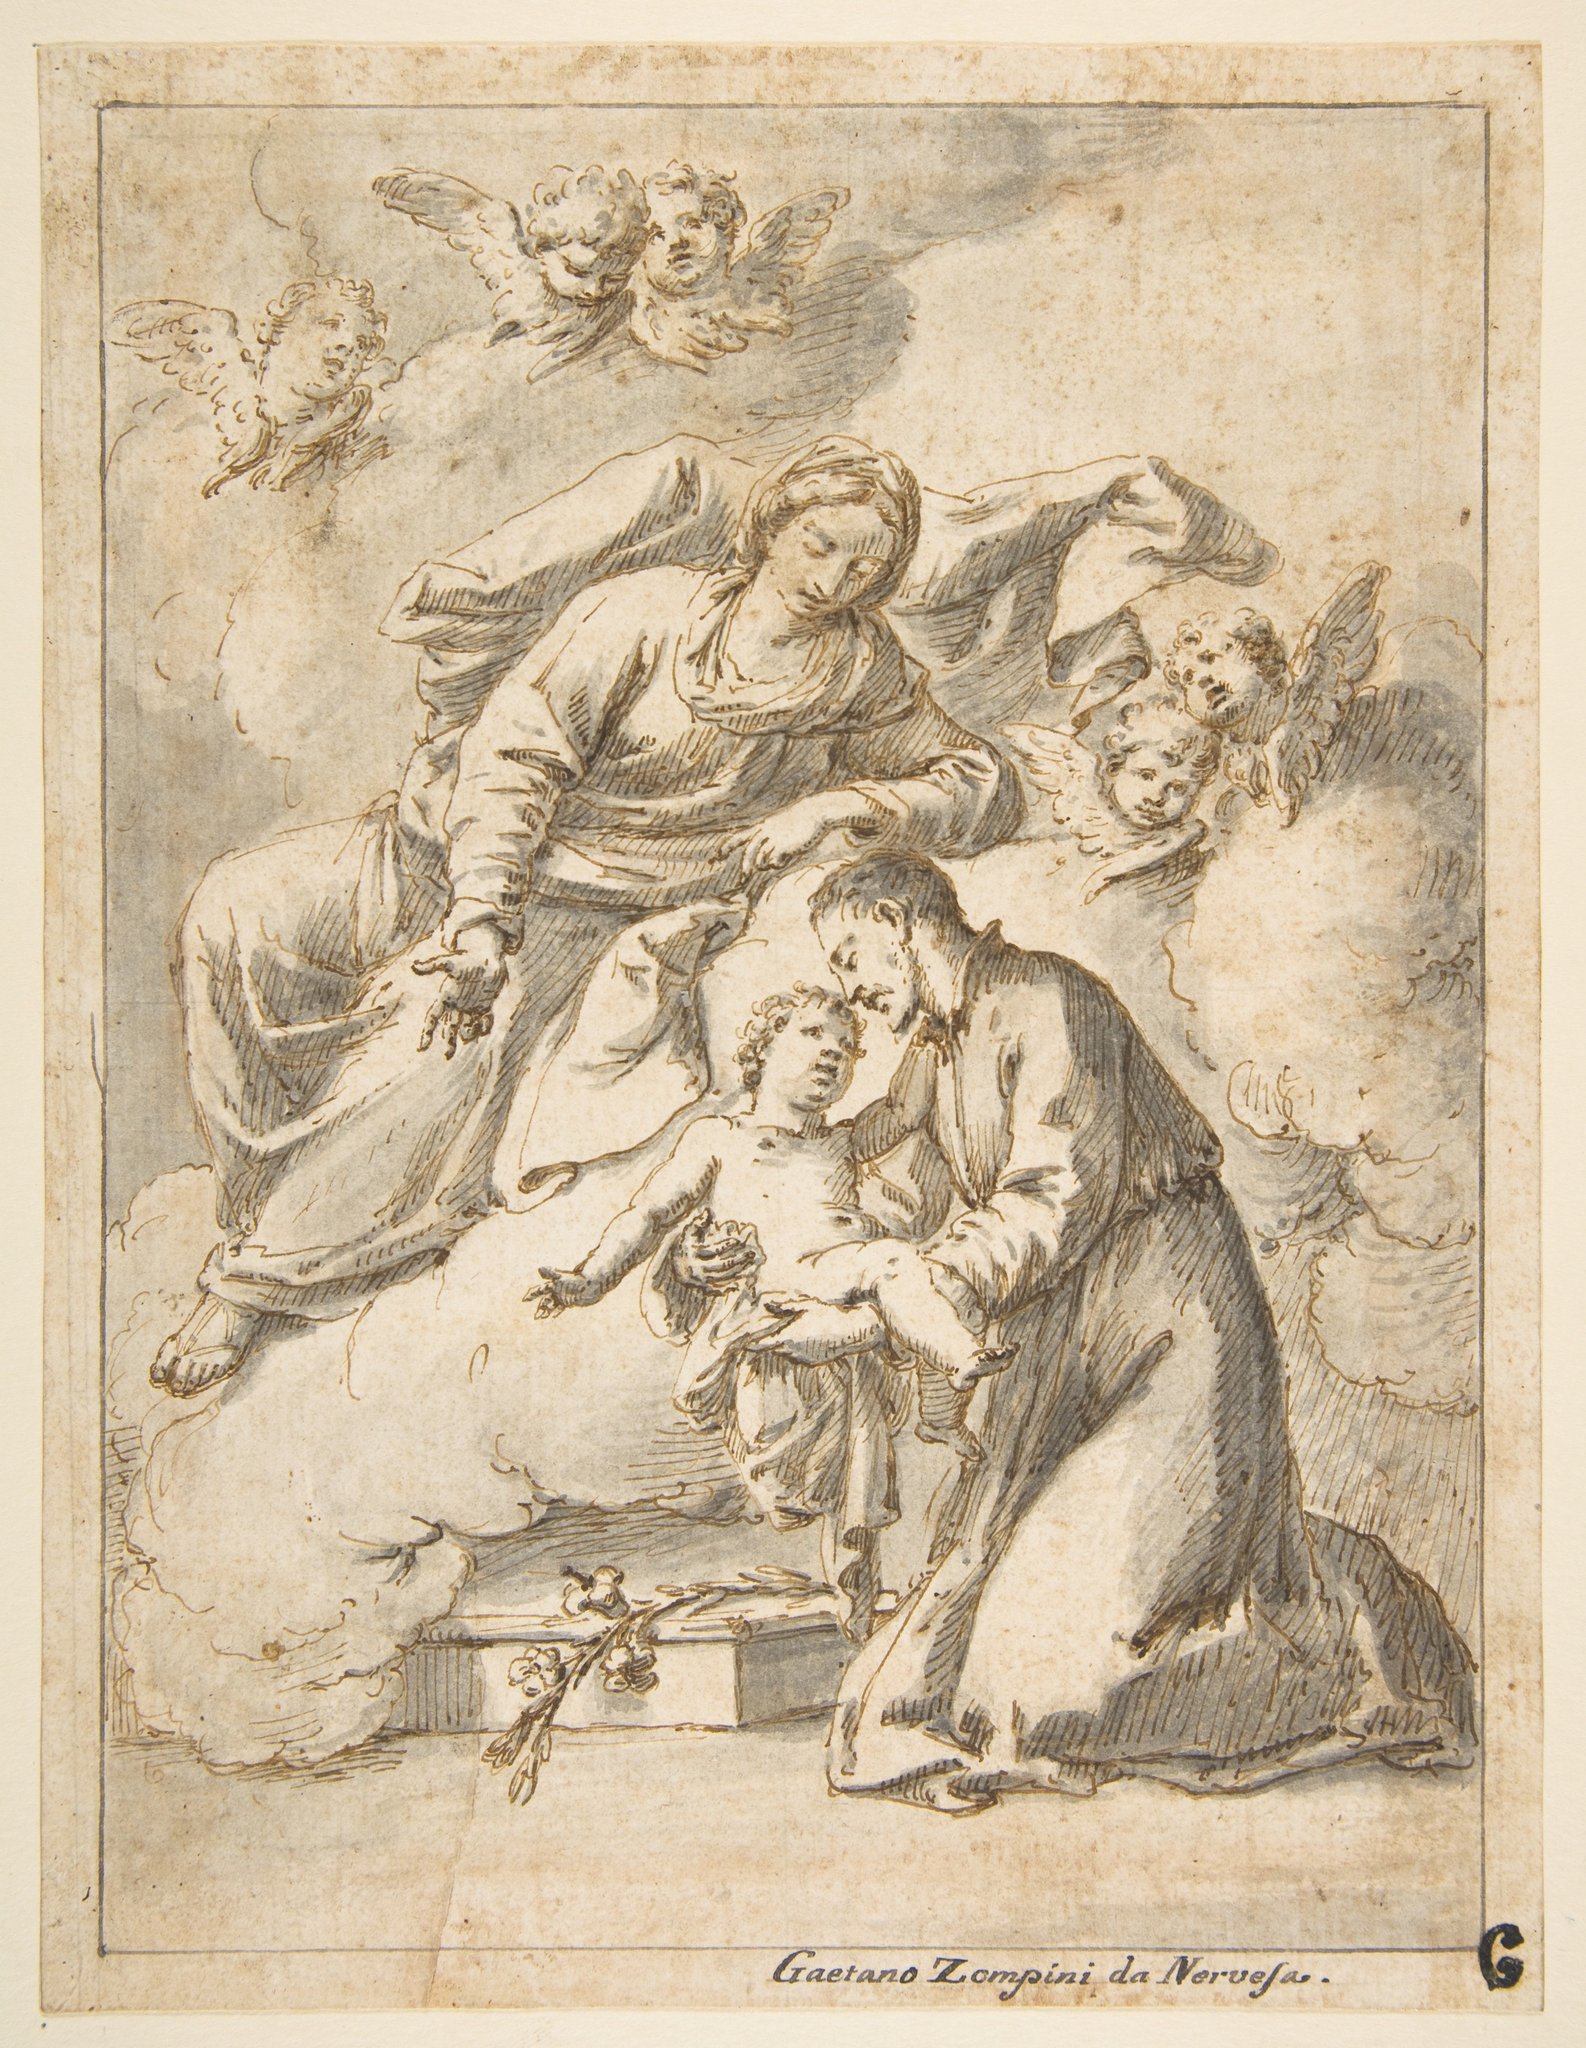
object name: drawing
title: Saint Cajetan of Thiene Holding the Infant Jesus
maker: gaetano gherardo zompini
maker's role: artist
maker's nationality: italian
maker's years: 1700-1778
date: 1730-1740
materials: ink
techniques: brush, pen, wash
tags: cupid,virgin mary,jesus,saints